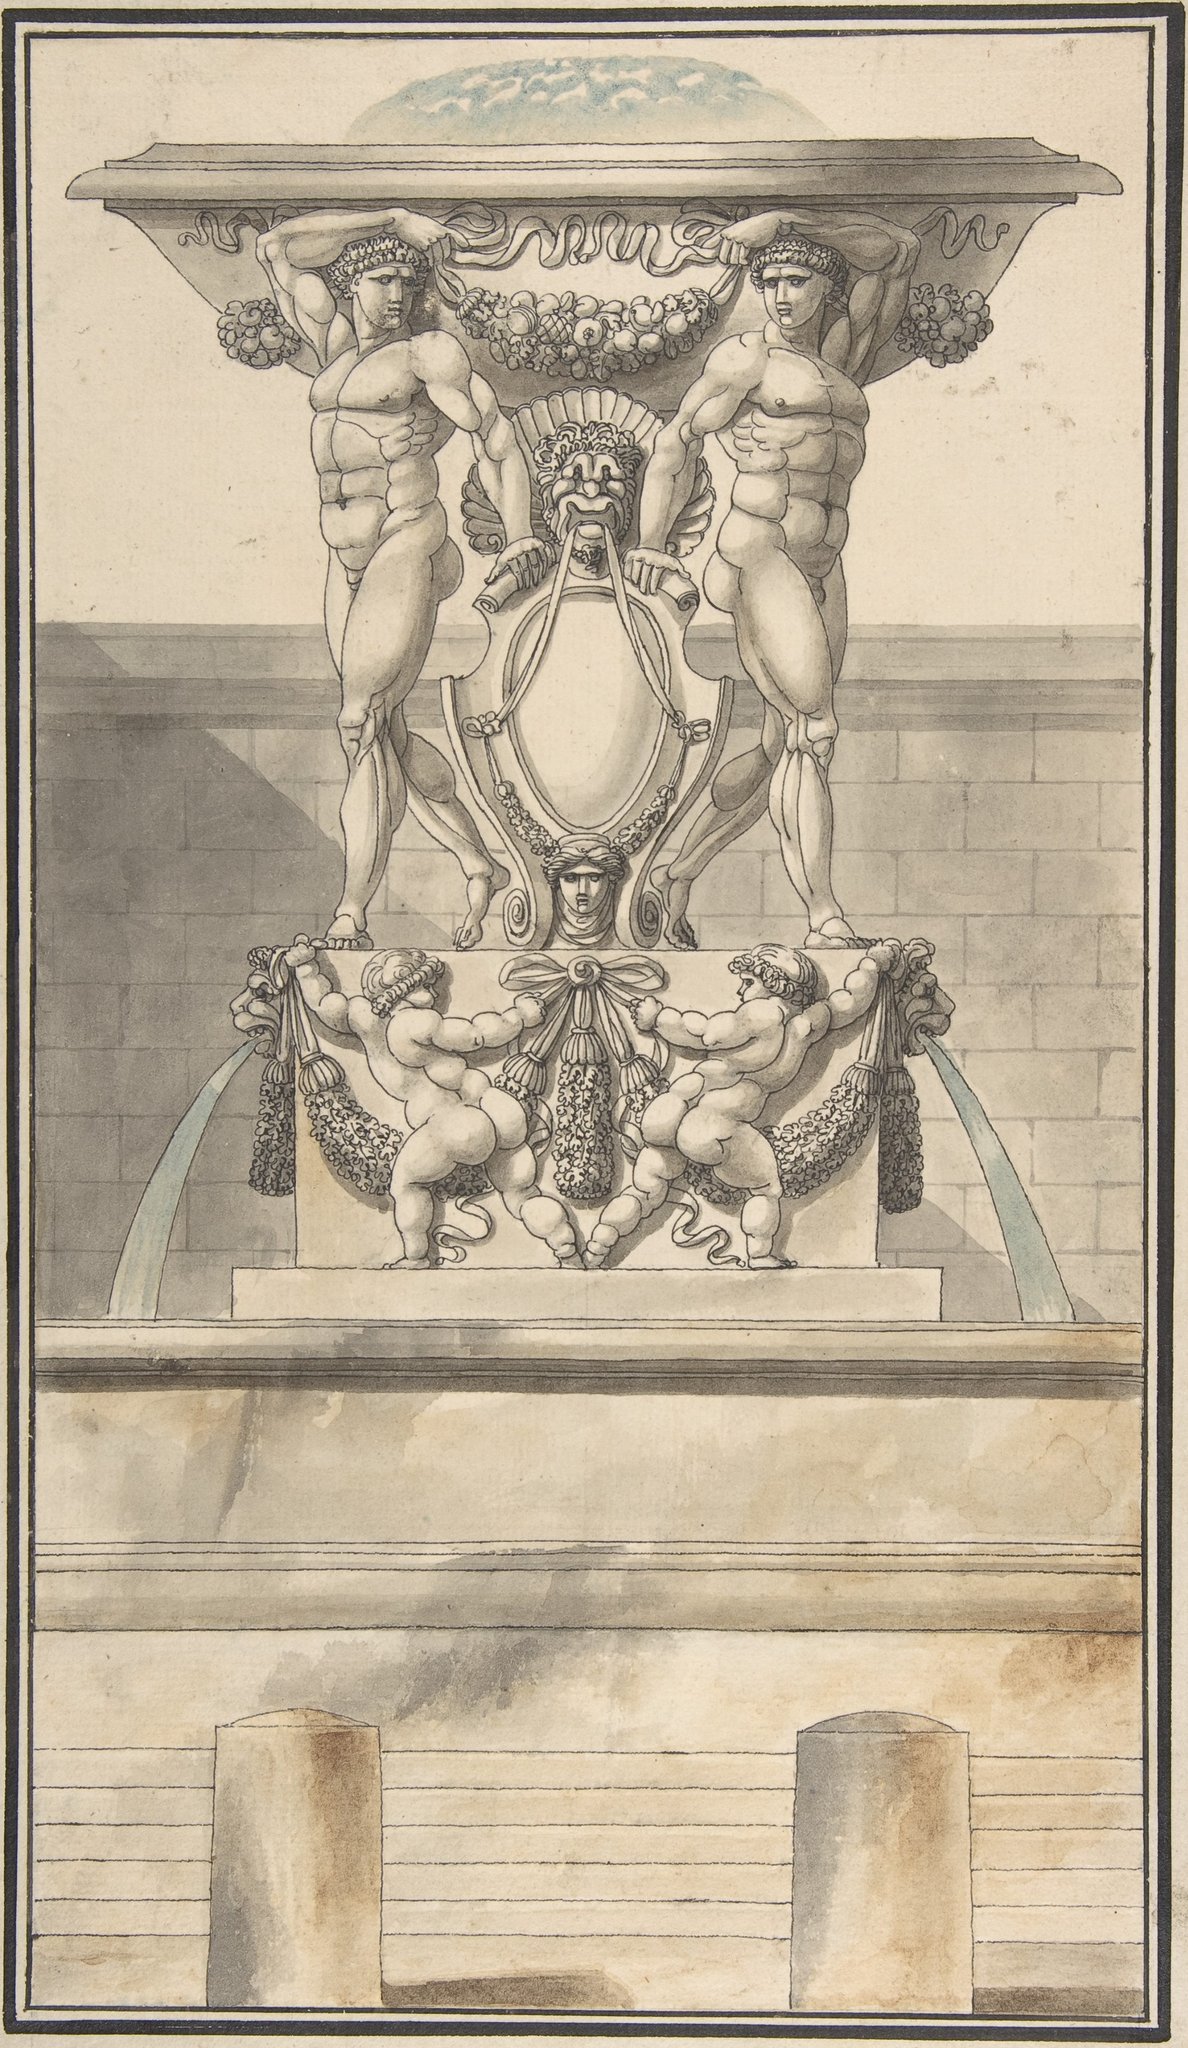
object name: drawing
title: Design for a Fountain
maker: charles pierre joseph normand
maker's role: artist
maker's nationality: french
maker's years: 1765-1840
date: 1765-1840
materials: ink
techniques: brush, pen, wash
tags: fountains,garlands,faces,boys,men